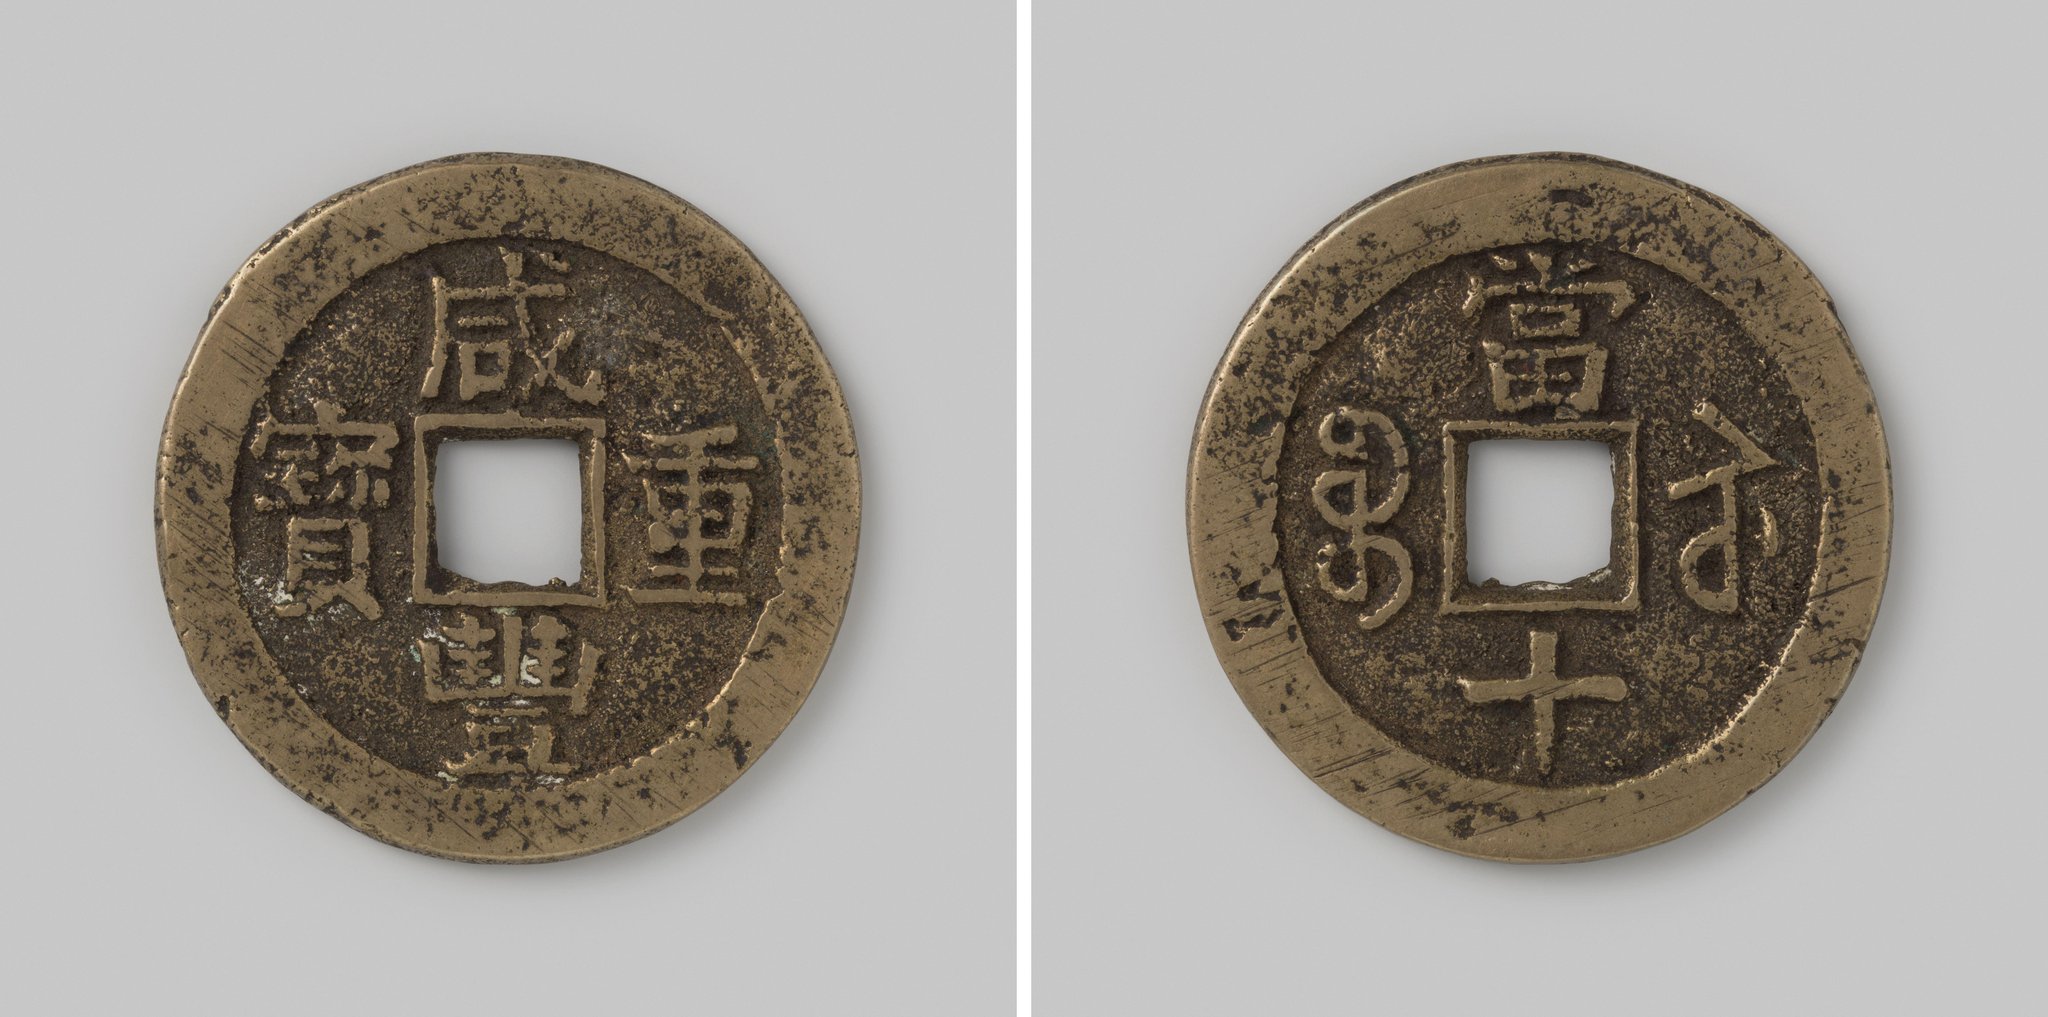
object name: coin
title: 10 cash van het keizerrijk China van keizer Wen Tsung onder de regeringsnaam Hsien-Feng,1851 -1861 uit Suchow in Kiangsu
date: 1851-1861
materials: copper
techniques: casting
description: Koperen munt. Voorzijde: binnen brede opstaande rand rondom vierkante uitsparing in het midden vier kruisgewijze geplaatste Chinese tekens, waarvan twee met de betekenis: Hsien feng. Keerzijde: binnen brede opstaande rand rondom vierkante uitsparing in het midden drie Chinese tekens, waarbij het rechter teken met de betekenis: Su = Suchow, in de provincie Kiangsu, met onderaan een plus-teken [=10].